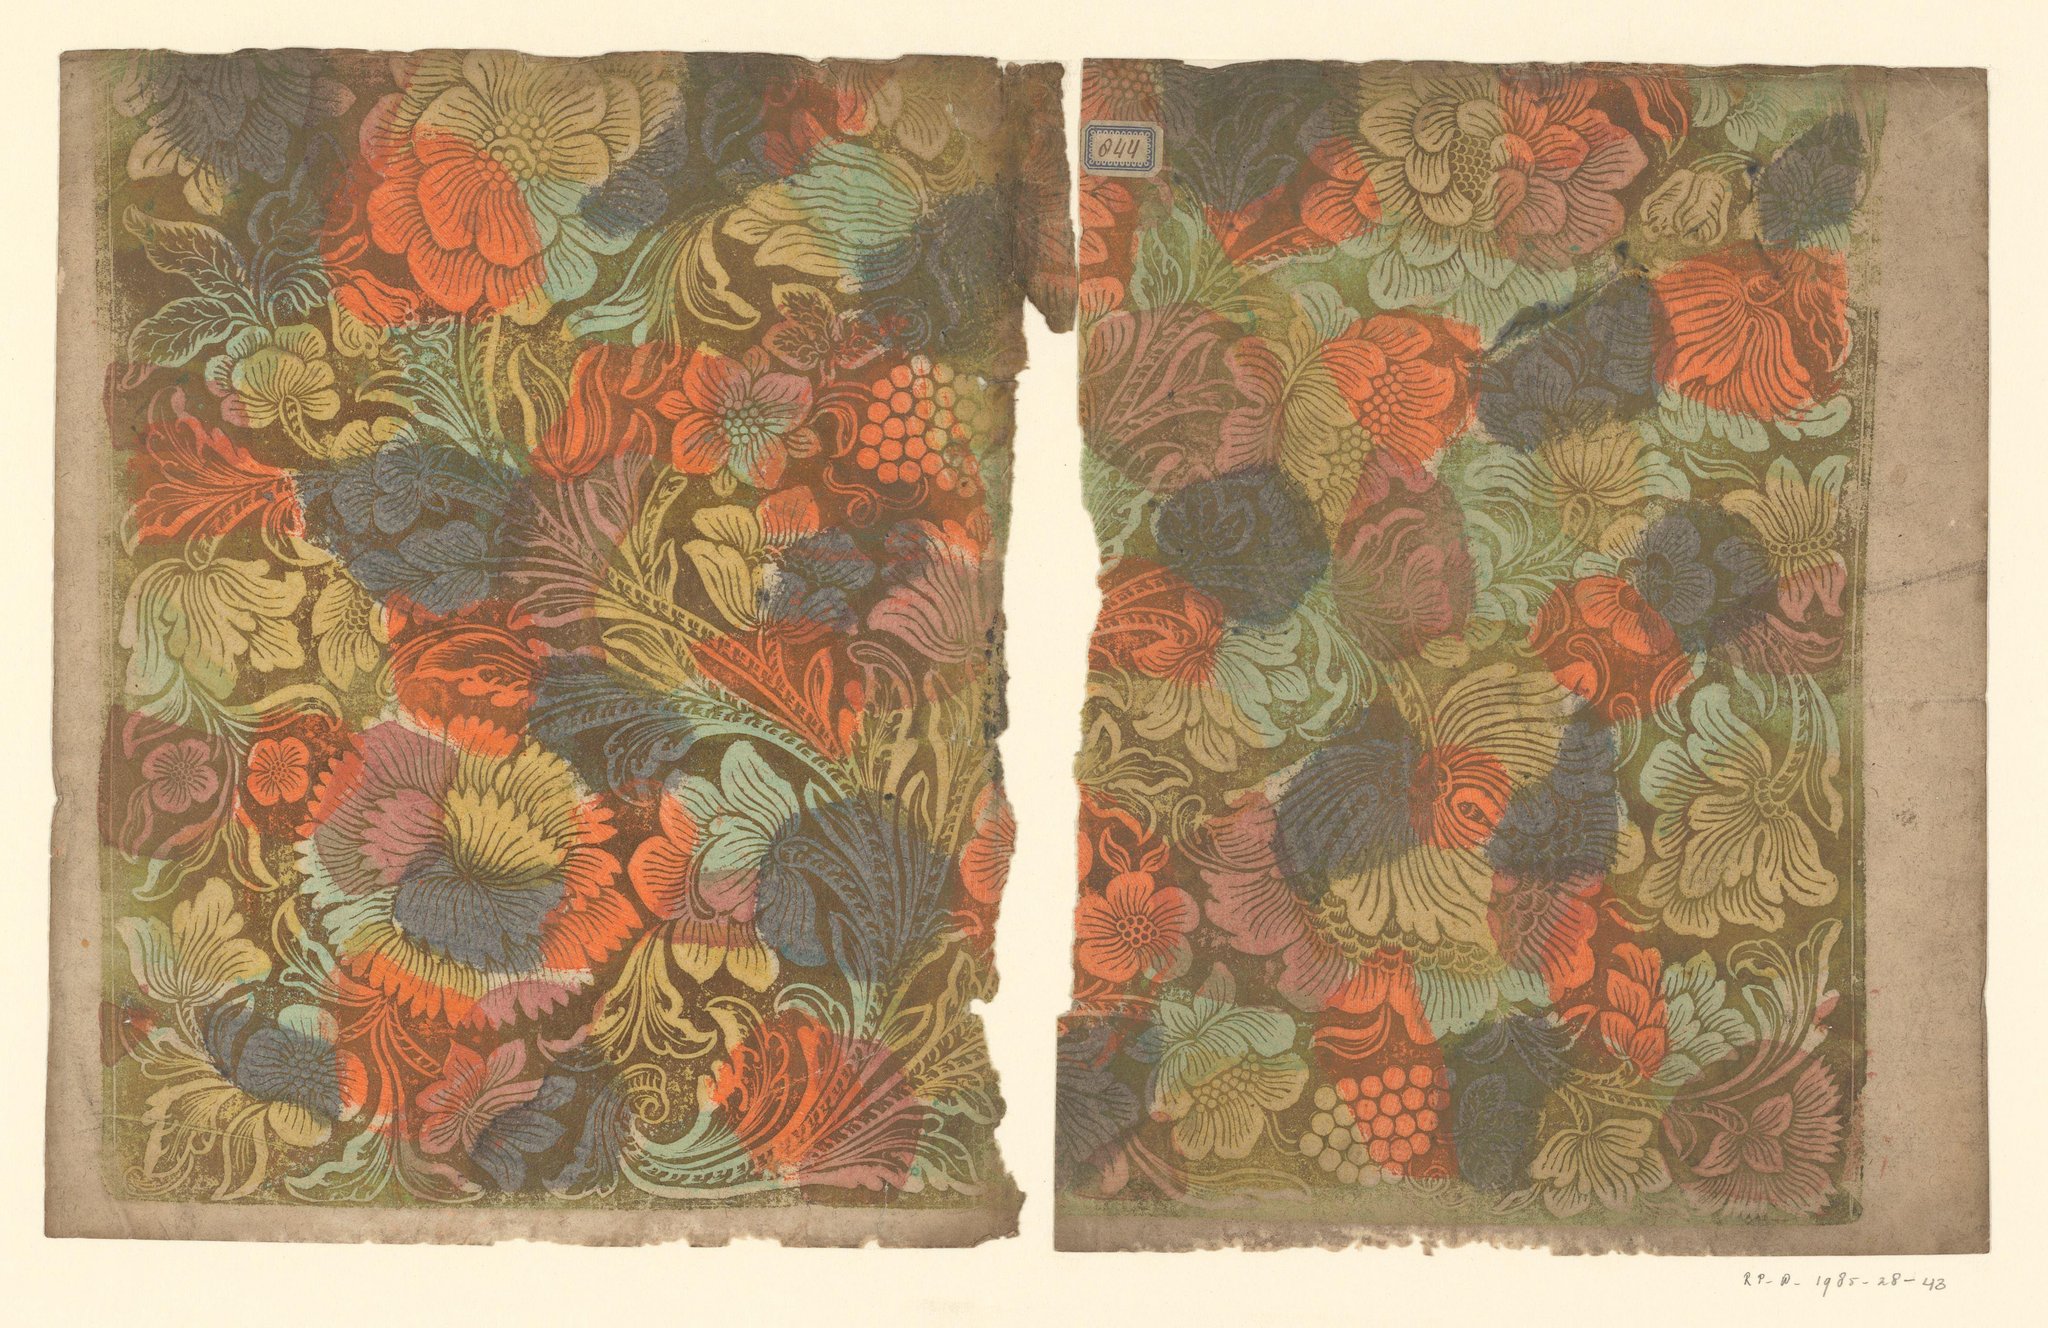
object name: brocade paper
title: Blad met bloemen en vruchten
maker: Anonymous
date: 1700-1850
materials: gold leaf, paint, paper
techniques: relief print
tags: ornament derived from plant forms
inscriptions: collector's mark: Lugt 2228, collector's mark: Lugt 2760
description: Blad met patroon van bloemen en vruchten. Omslag in twee losse delen gescheurd, op het rechterdeel een met opschrift: '844'.